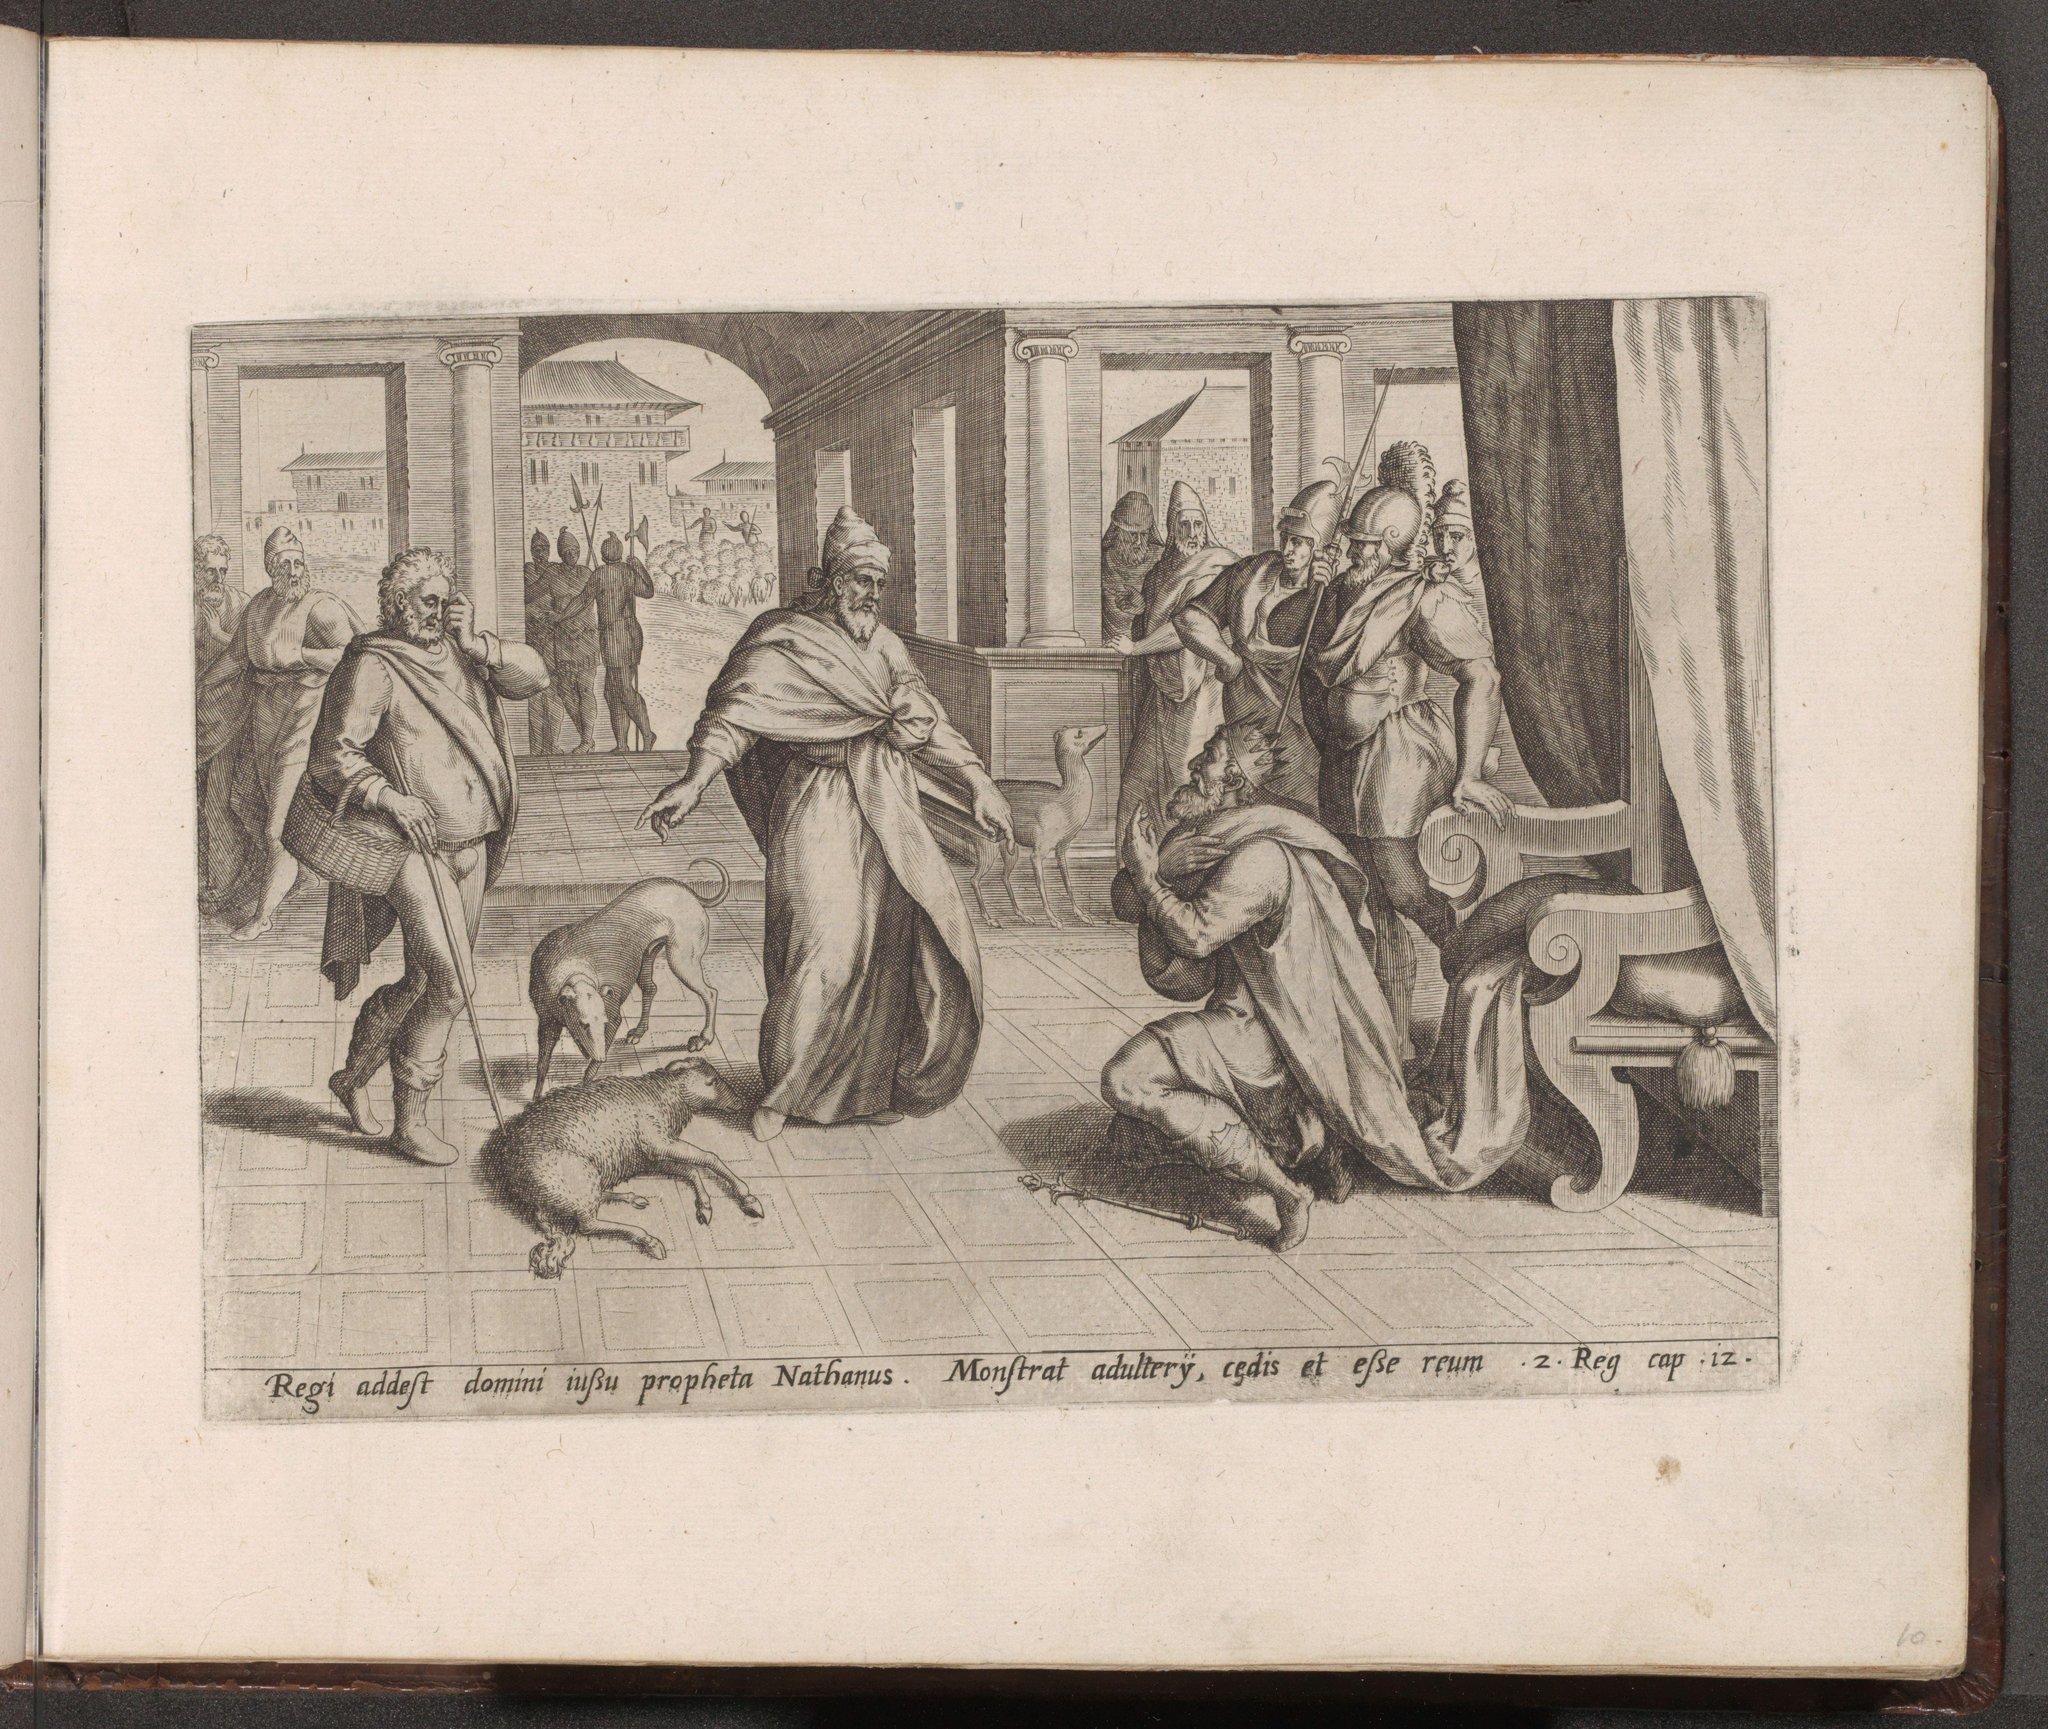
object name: print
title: Historia Bersabee (...)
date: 1579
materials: paper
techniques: engraving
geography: antwerp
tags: nathan's parable: the rich man takes the poor man's lamb to prepare it for his guest, david rebuked by nathan, lamb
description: De profeet Natan komt bij koning David en vertelt hem een parabel over een rijke man, die het lam van een arme man afpakte en het slachtte. Natan wijst daarbij op de arme man en het gestorven lam naast zich. Met deze parabel vertelt Natan dat David heeft gehandeld zoals de rijke man. David knielt en erkent dat hij gezondigd heeft door overspel te plegen met Batseba en haar man Uria te laten doden. Onder de voorstelling een verwijzing in het Latijn naar de Bijbeltekst in 2 Sam. 12. Prent maakt deel uit van een album.